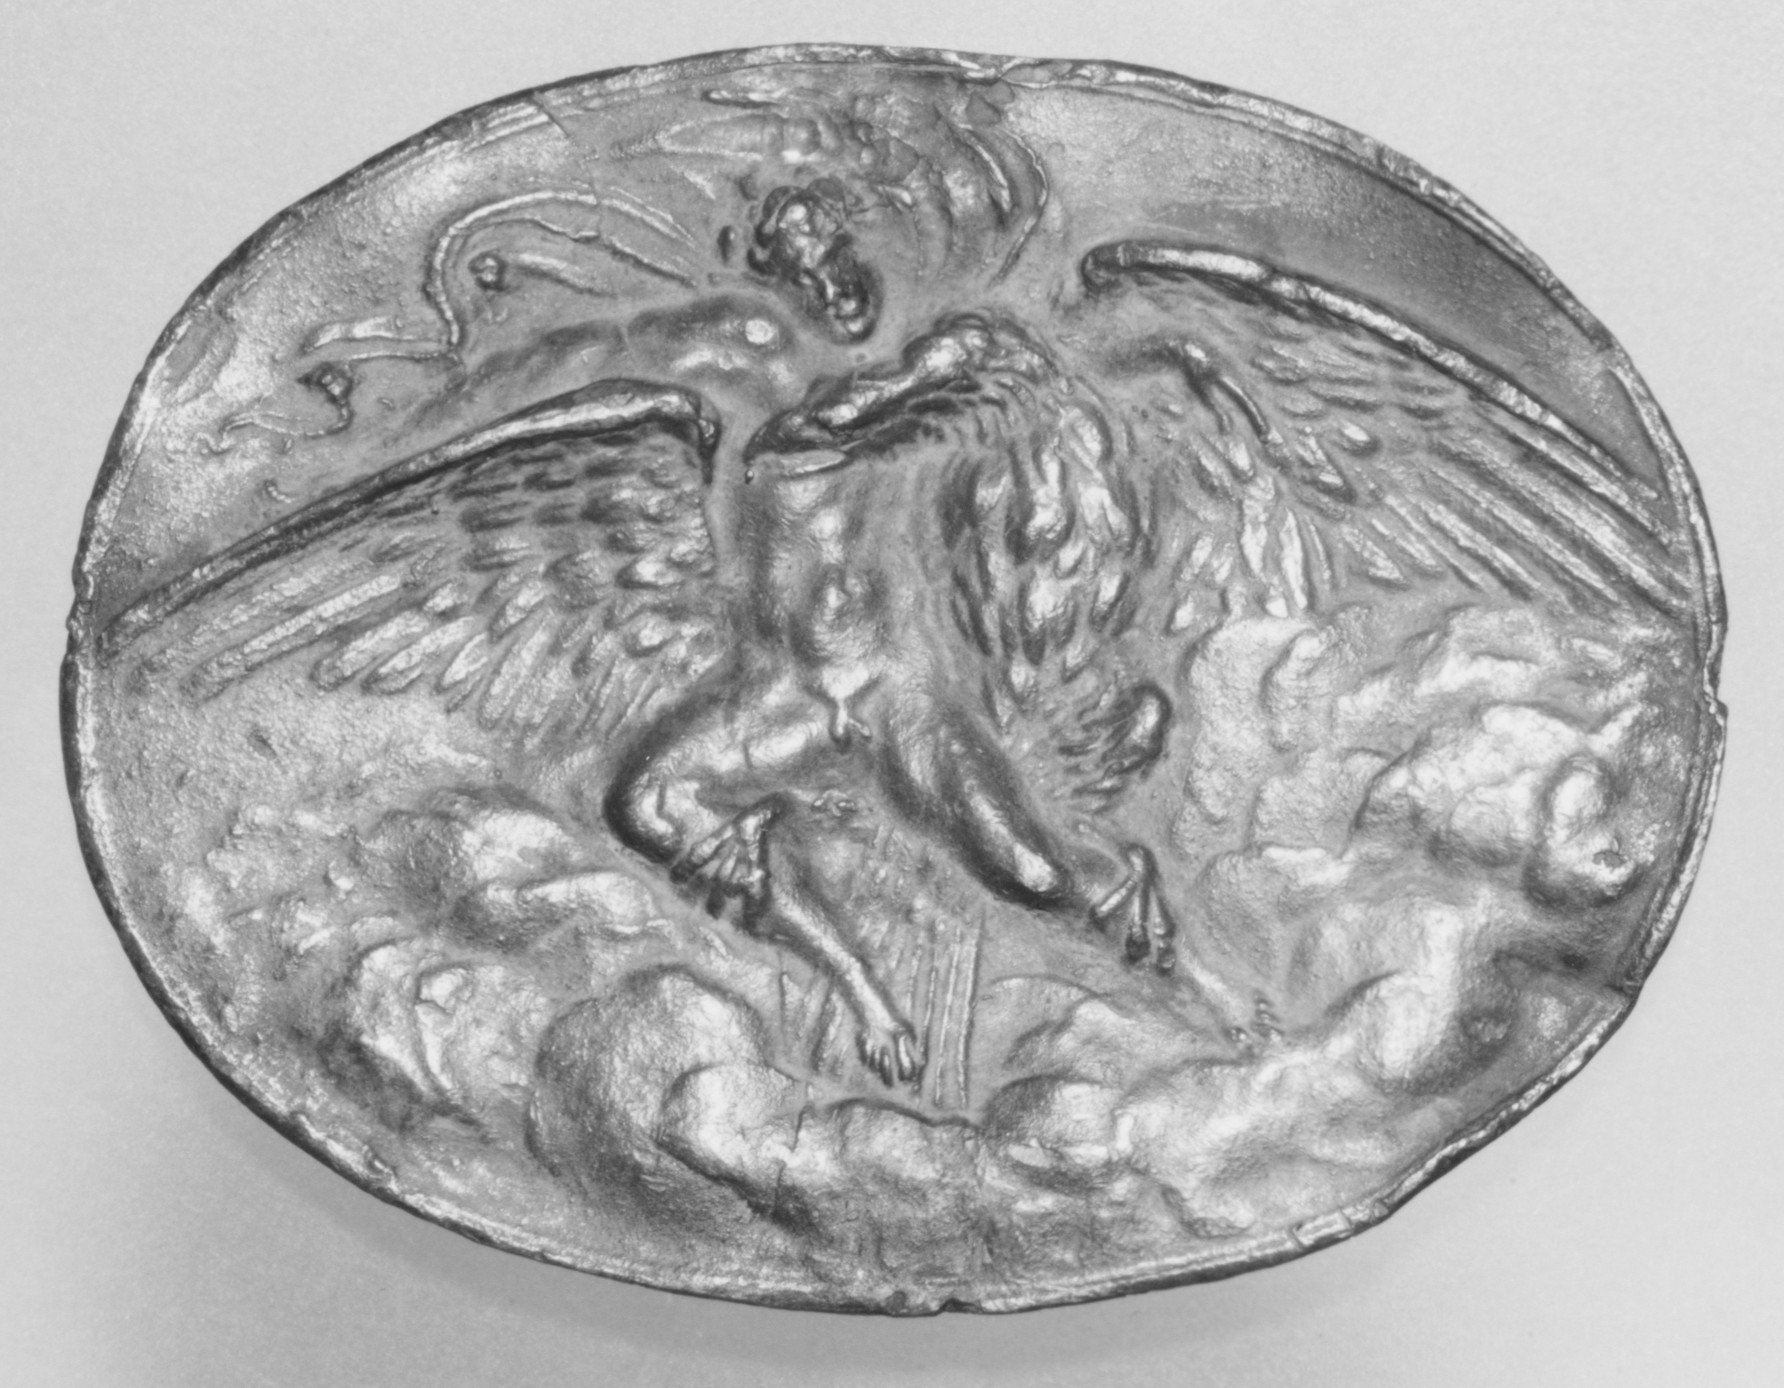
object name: plaquette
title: The Rape of Ganymede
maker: giovanni bernardi da castel bolognese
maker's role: artist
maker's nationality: italian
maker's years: 1494-1553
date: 1501-1600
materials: lead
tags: eagles,male nudes